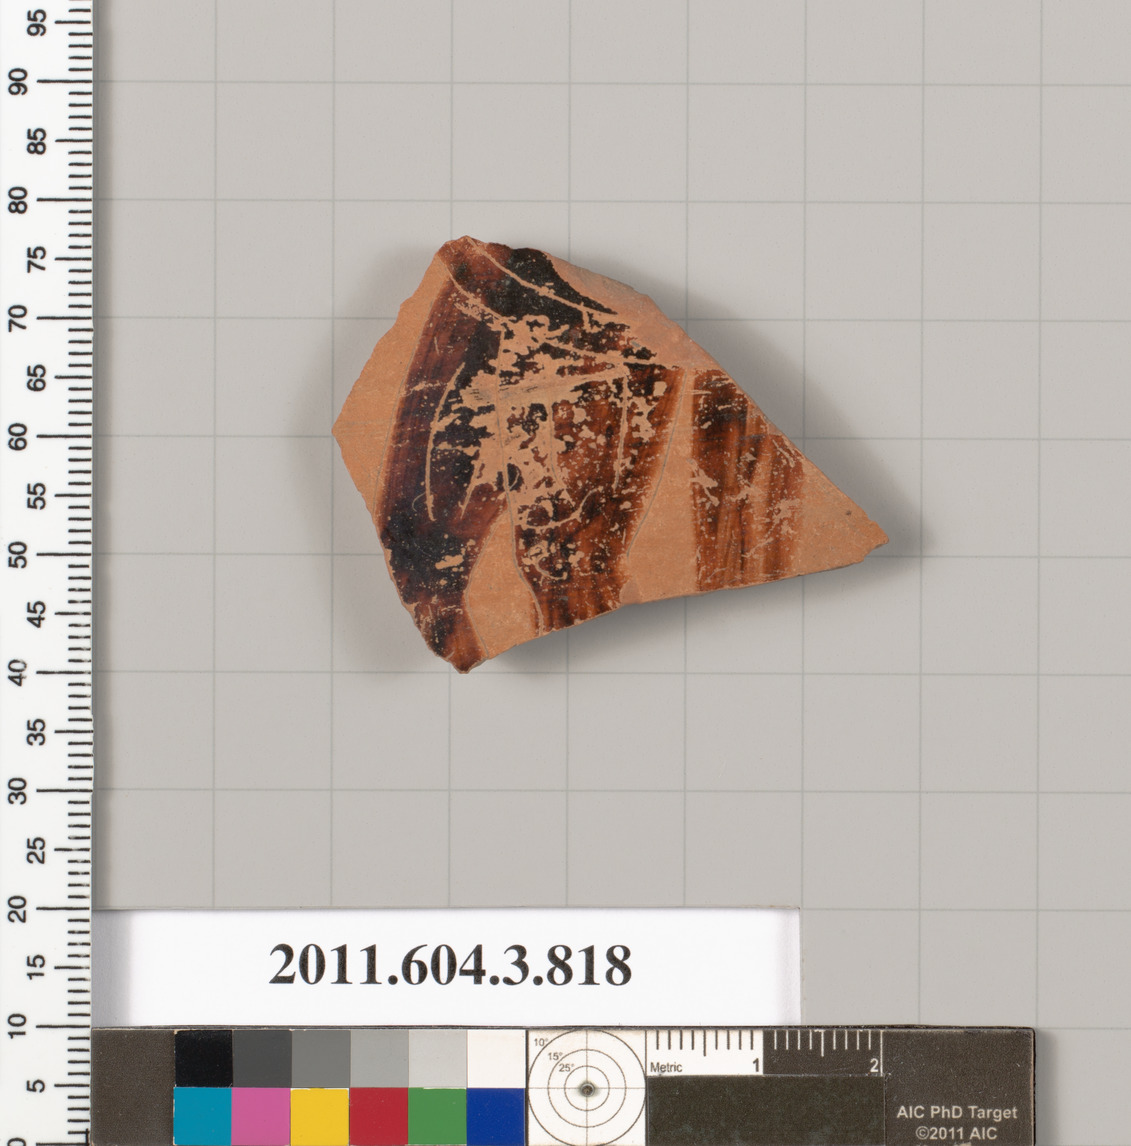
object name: lekythos fragment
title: Terracotta fragment of a lekythos (oil flask)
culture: greek, attic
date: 534-501 BCE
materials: terracotta